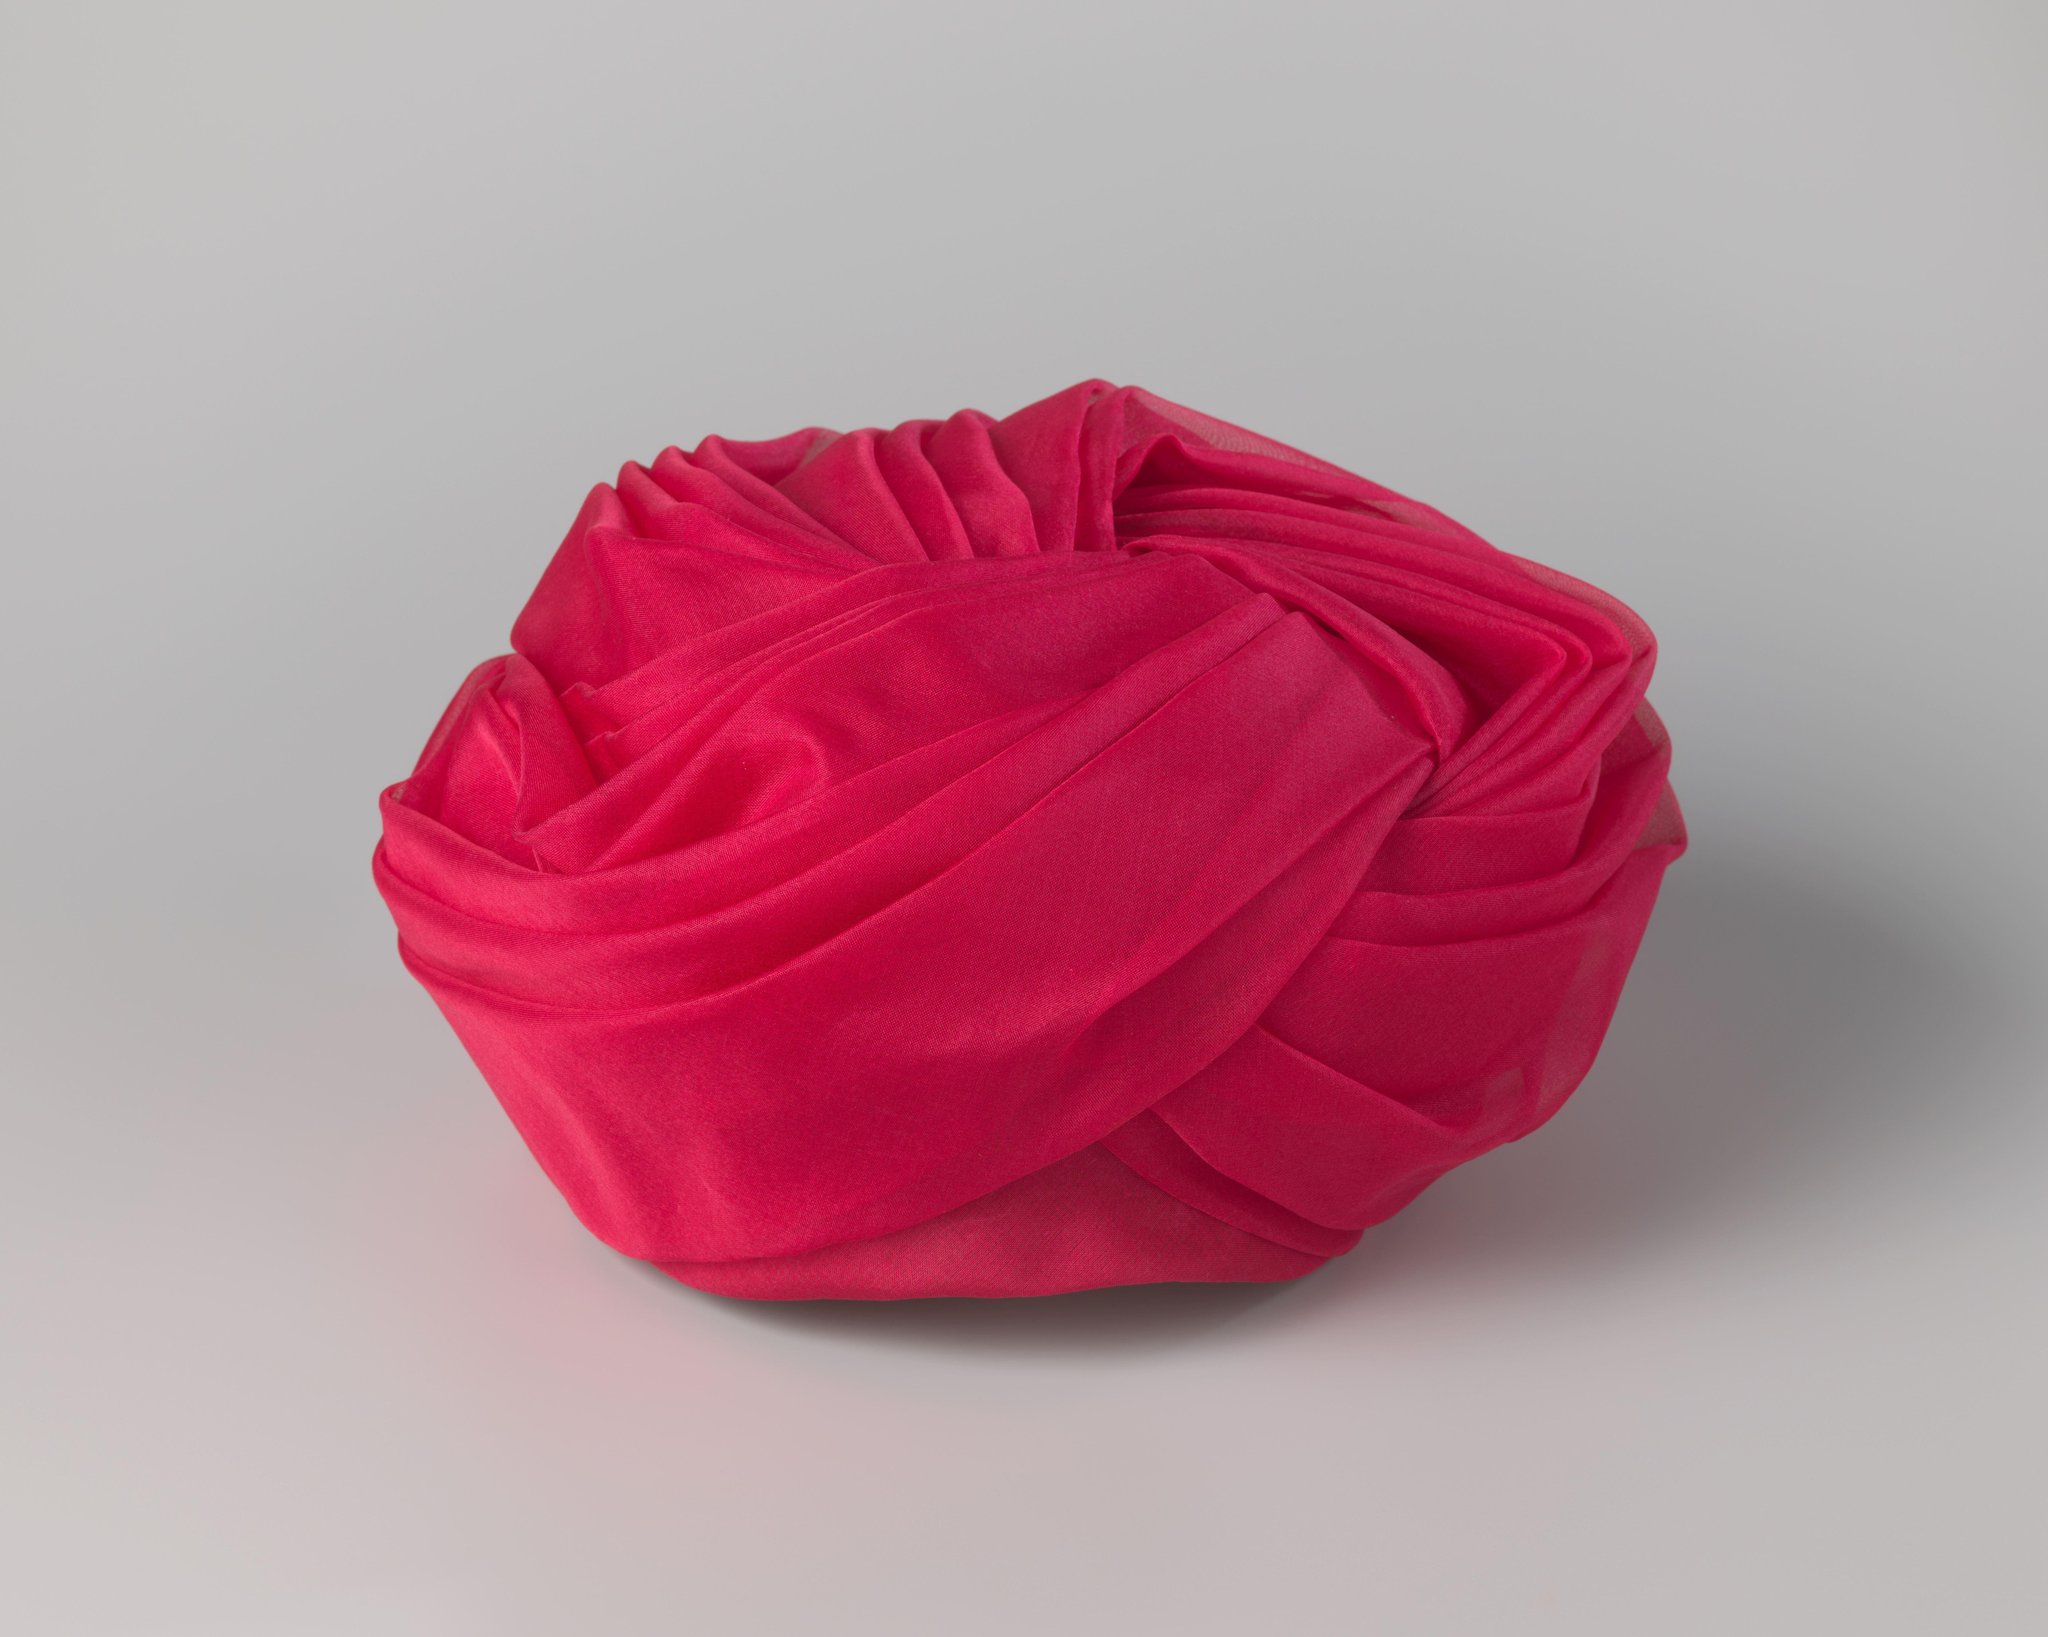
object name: hat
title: Tulband van shocking pink crêpe georgette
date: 1966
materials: silk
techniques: crêpe binding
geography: zeist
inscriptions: address: ‘"Angélique"/ Slotlaan 12 Spec. zaak/ Maison Angélique/ P.J. Baars/ 't Rond-Zeist’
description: Tulband van shocking pink crêpe georgette. De crêpe is over een binnenwerk van sparterie gedrapeerd. De voering is evenees van crêpe. Roze rood ripslint als hoedeband. Aan de binnenzijde is een label genaaid waarop het adres: "Angélique"/ Slotlaan 12 Spec. zaak/ Maison Angélique/ P.J. Baars/ 't Rond-Zeist.